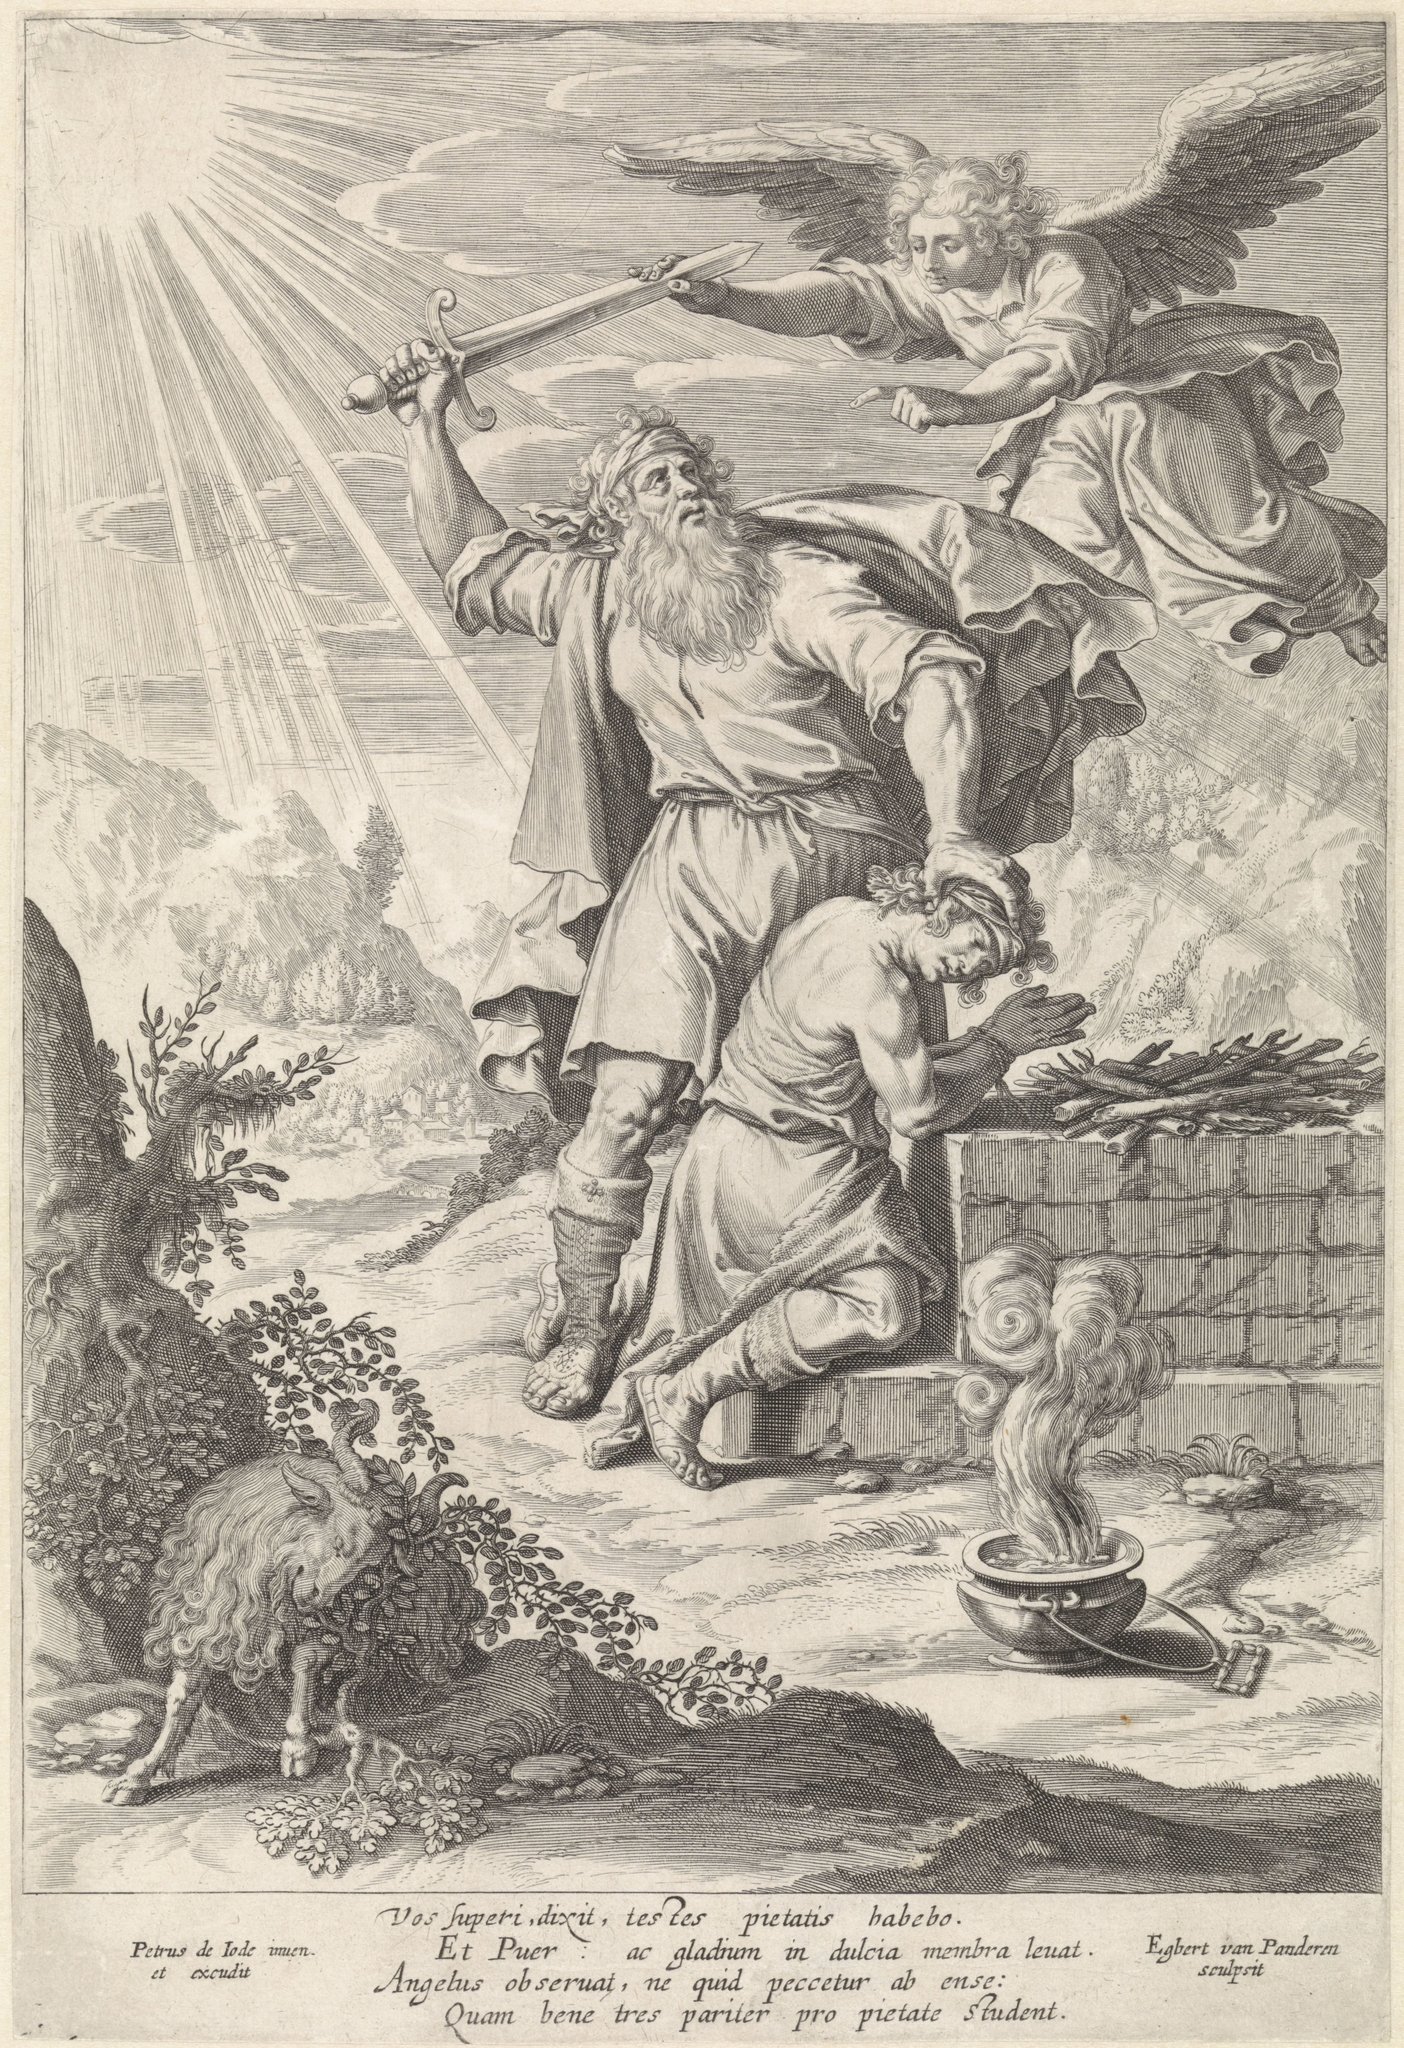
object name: print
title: Offer van Abraham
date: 1590-1637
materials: paper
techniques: engraving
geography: antwerp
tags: the sacrifice of isaac (genesis 22)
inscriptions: collector's mark: Lugt 2228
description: Abraham heft zijn zwaard om zijn zoon Isaak, die met de handen vastgebonden voor het altaar knielt, te doden. Een engel houdt hem tegen en wijst naar een ram die geofferd kan worden. In de marge een vierregelig onderschrift in het Latijn.